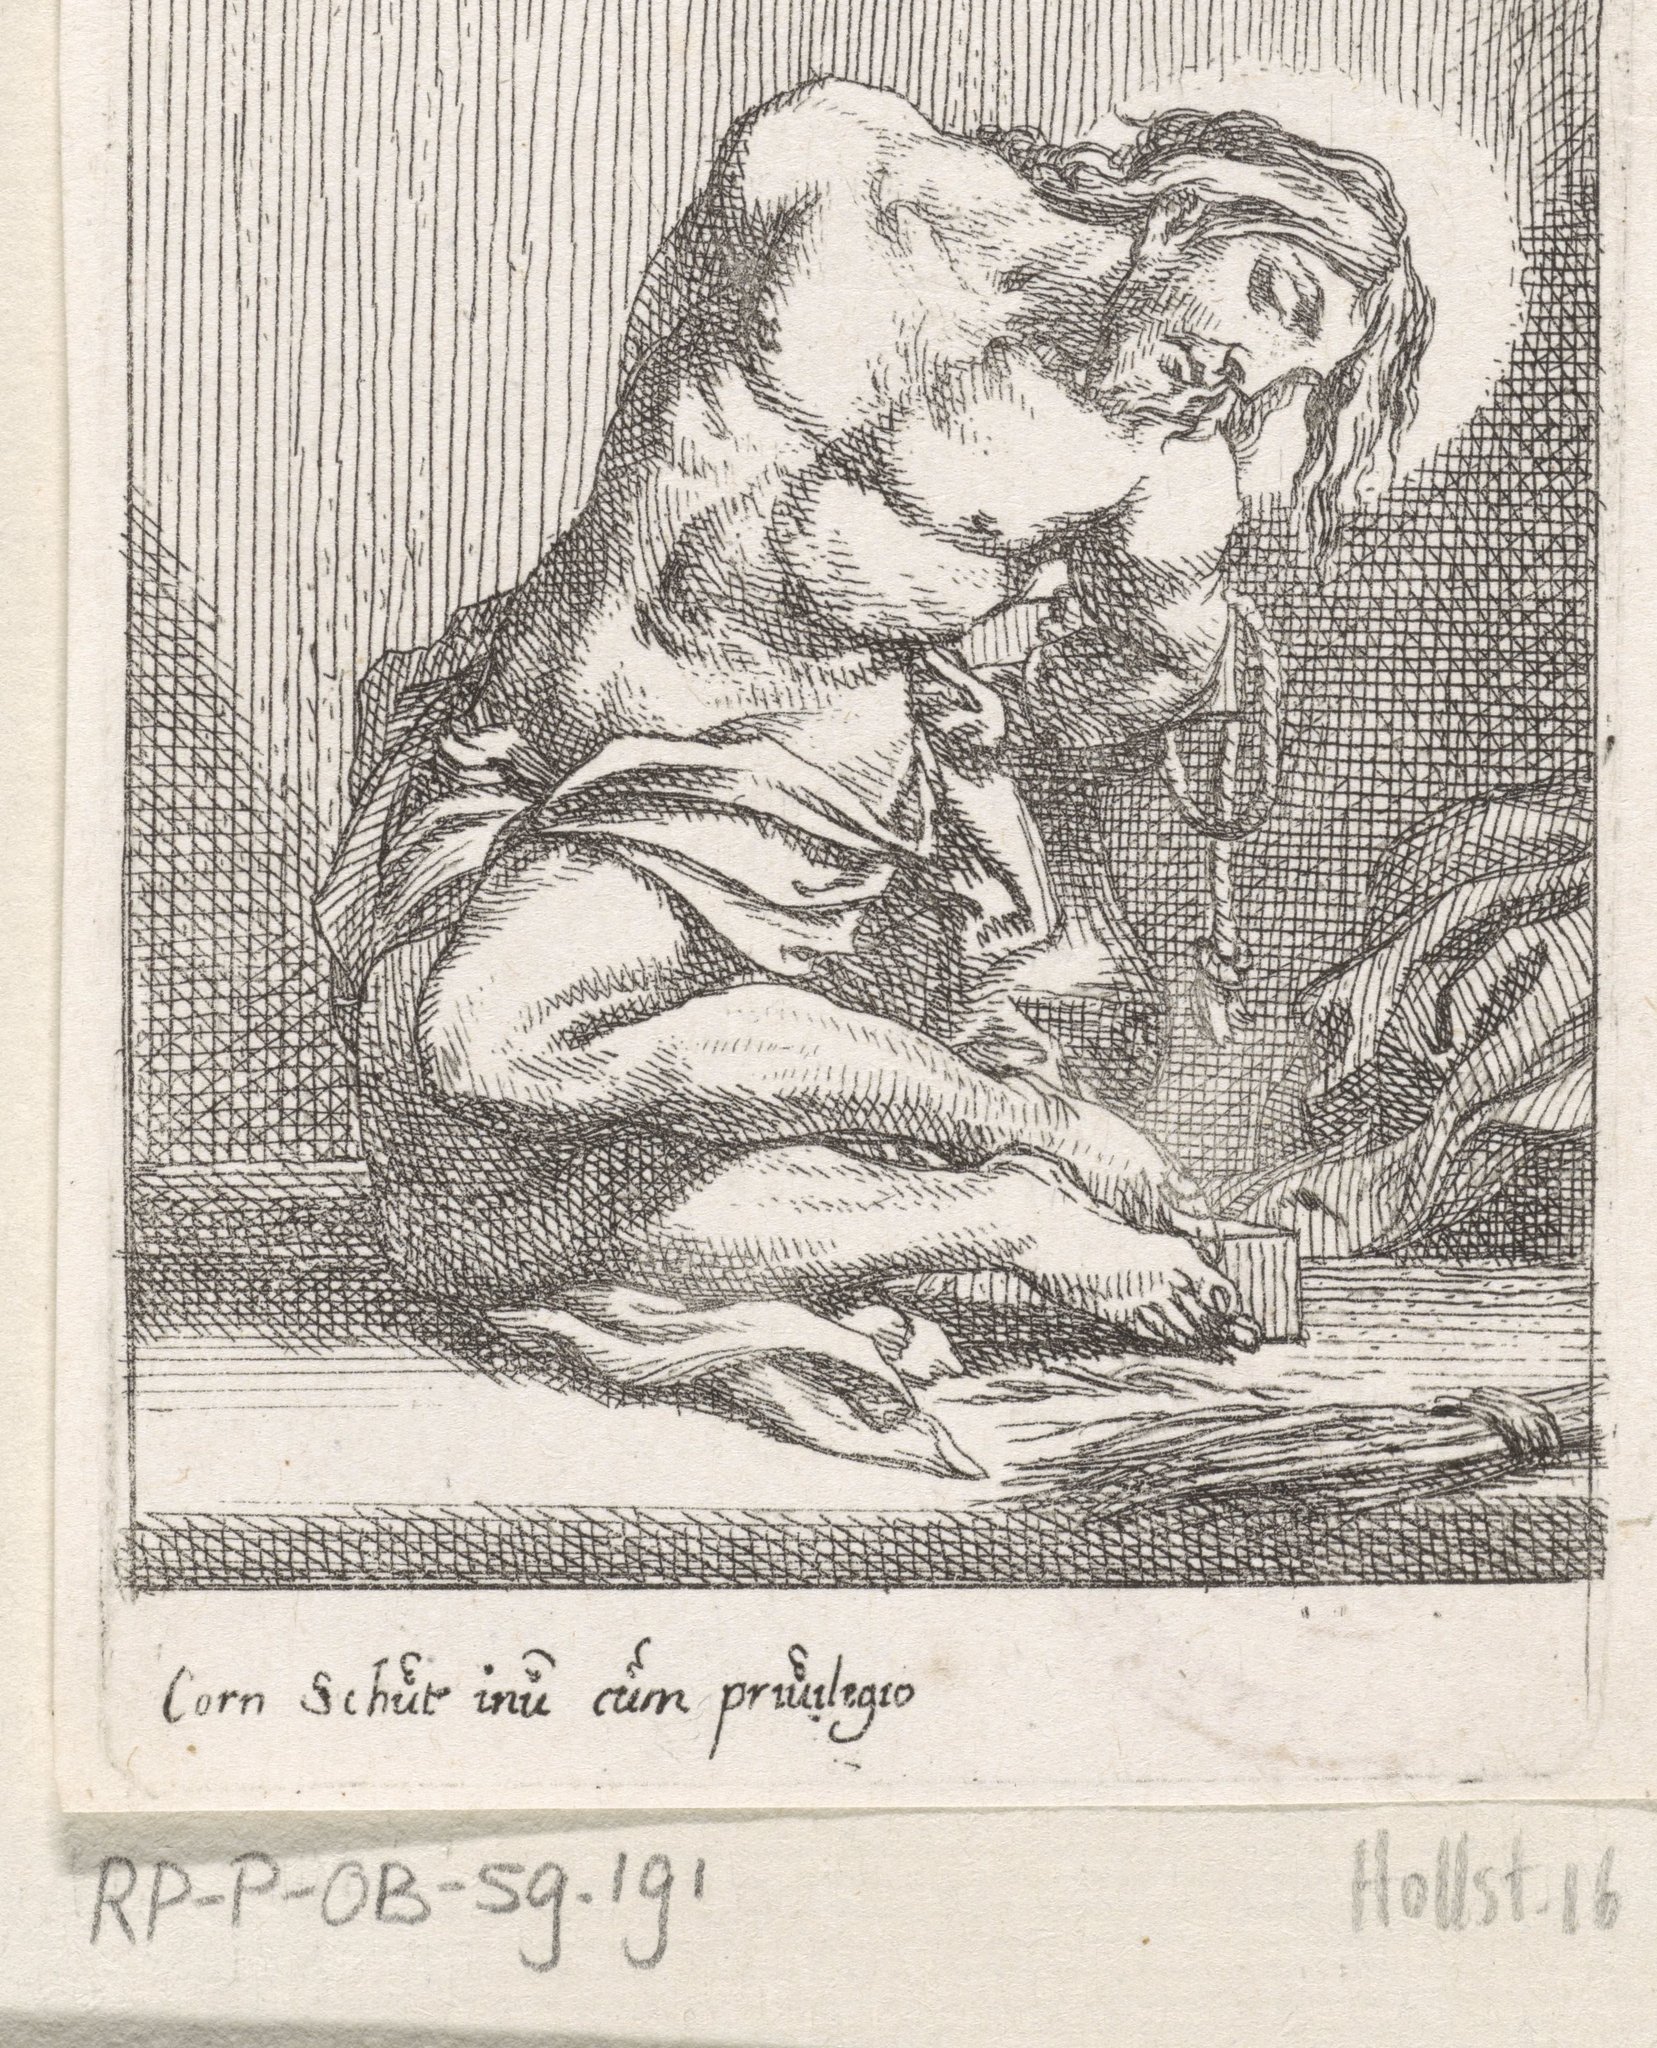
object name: print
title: Christus aan de geselpaal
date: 1618-1655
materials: paper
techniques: etching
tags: flagellation by soldiers, christ usually tied to a column (matthew 27:26; mark 15:15; john 19:1)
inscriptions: collector's mark: Lugt 240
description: Christus zit na de geseling ineengezakt op de grond, zijn handen nog vastgebonden aan de geselpaal; op de grond liggen zijn kleding en een roede van twijgen.